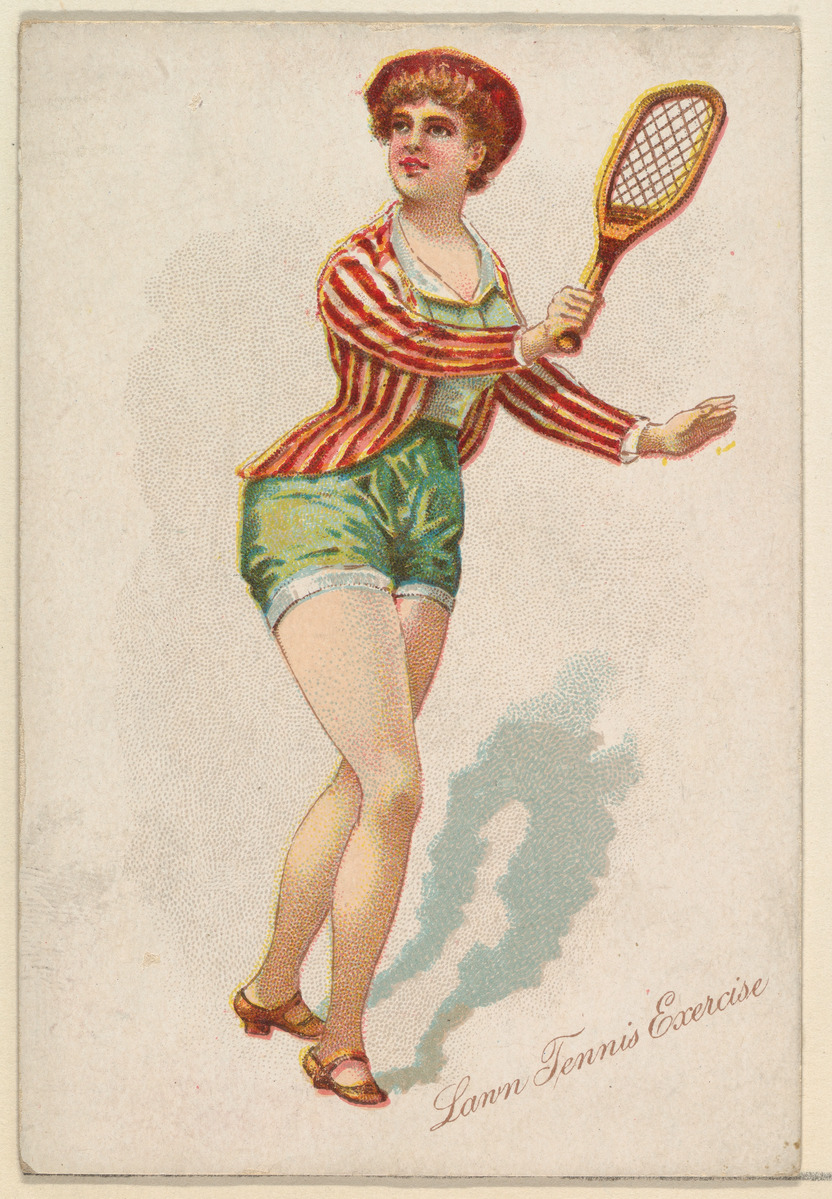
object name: print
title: Lawn Tennis Exercise, from the Pretty Athletes series (N196) issued by Wm. S. Kimball & Co.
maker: william s. kimball & company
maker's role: publisher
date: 1889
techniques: color lithograph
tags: women,athletes